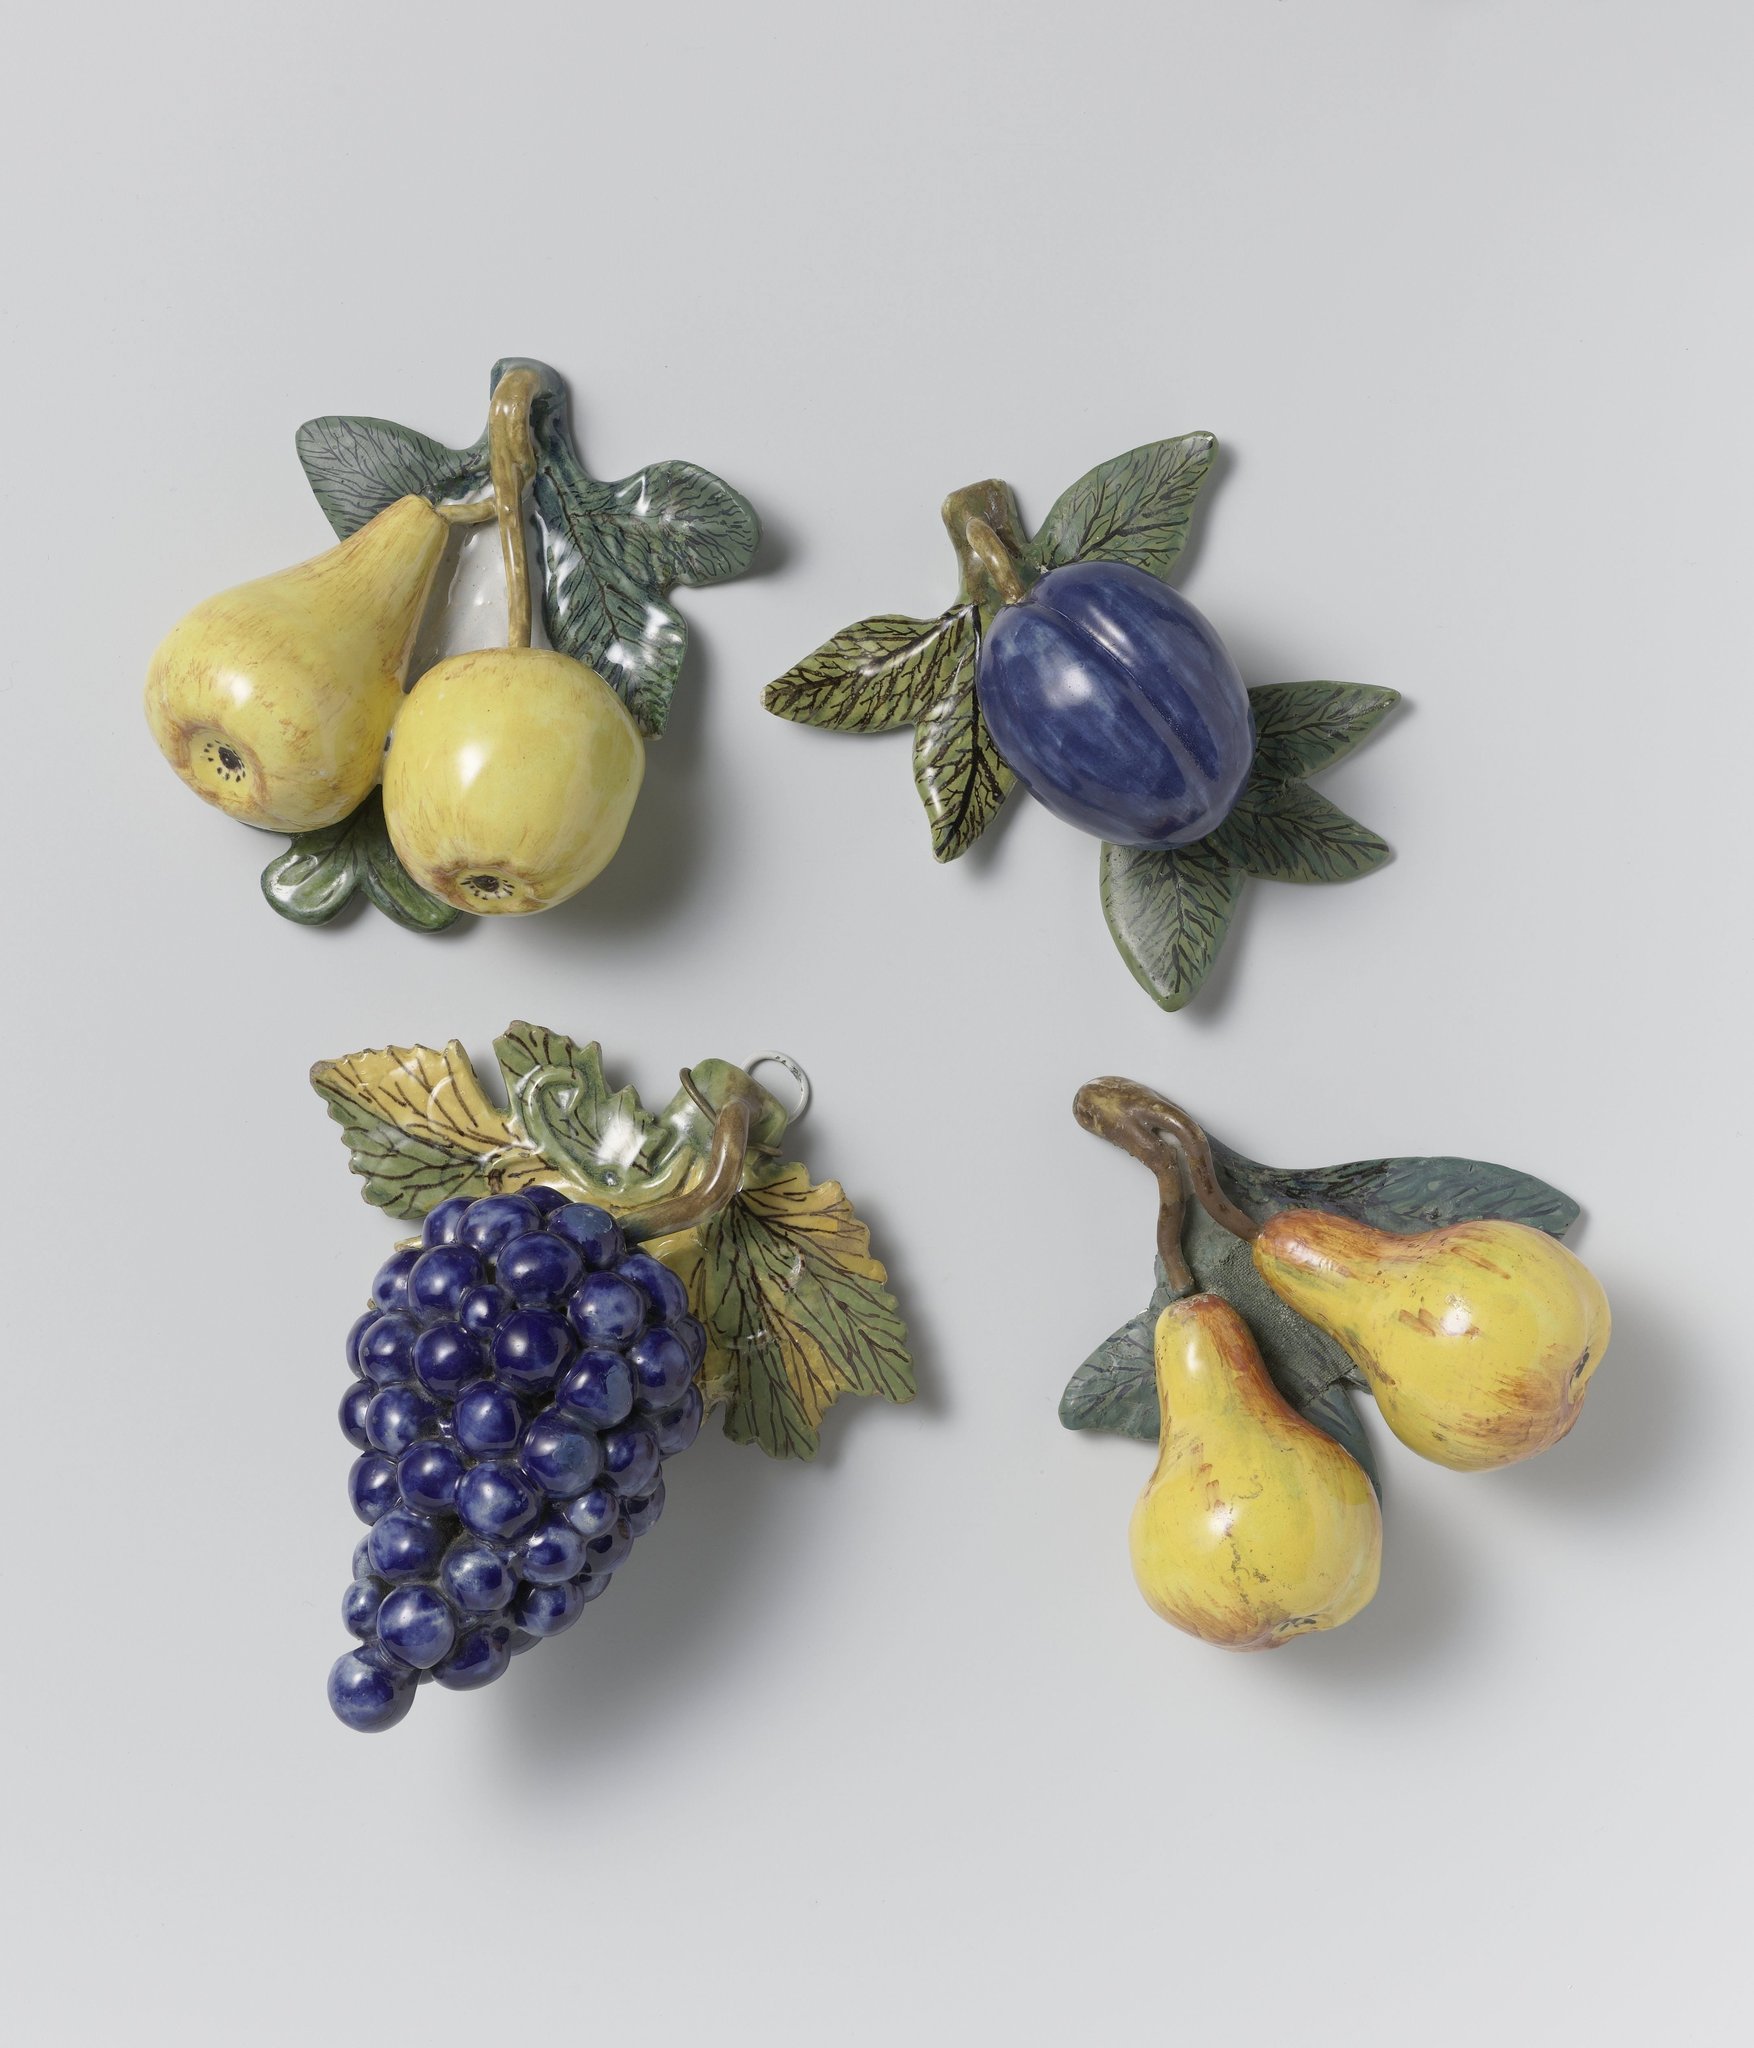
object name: decoratief object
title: Bunch of grapes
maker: Anonymous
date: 1750-1775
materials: earthenware, glaze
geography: delft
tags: bunch of grapes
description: Kunstfruit van faience, voorstellende een tros druiven op een druivenblad. Veelkleurig beschilderd.